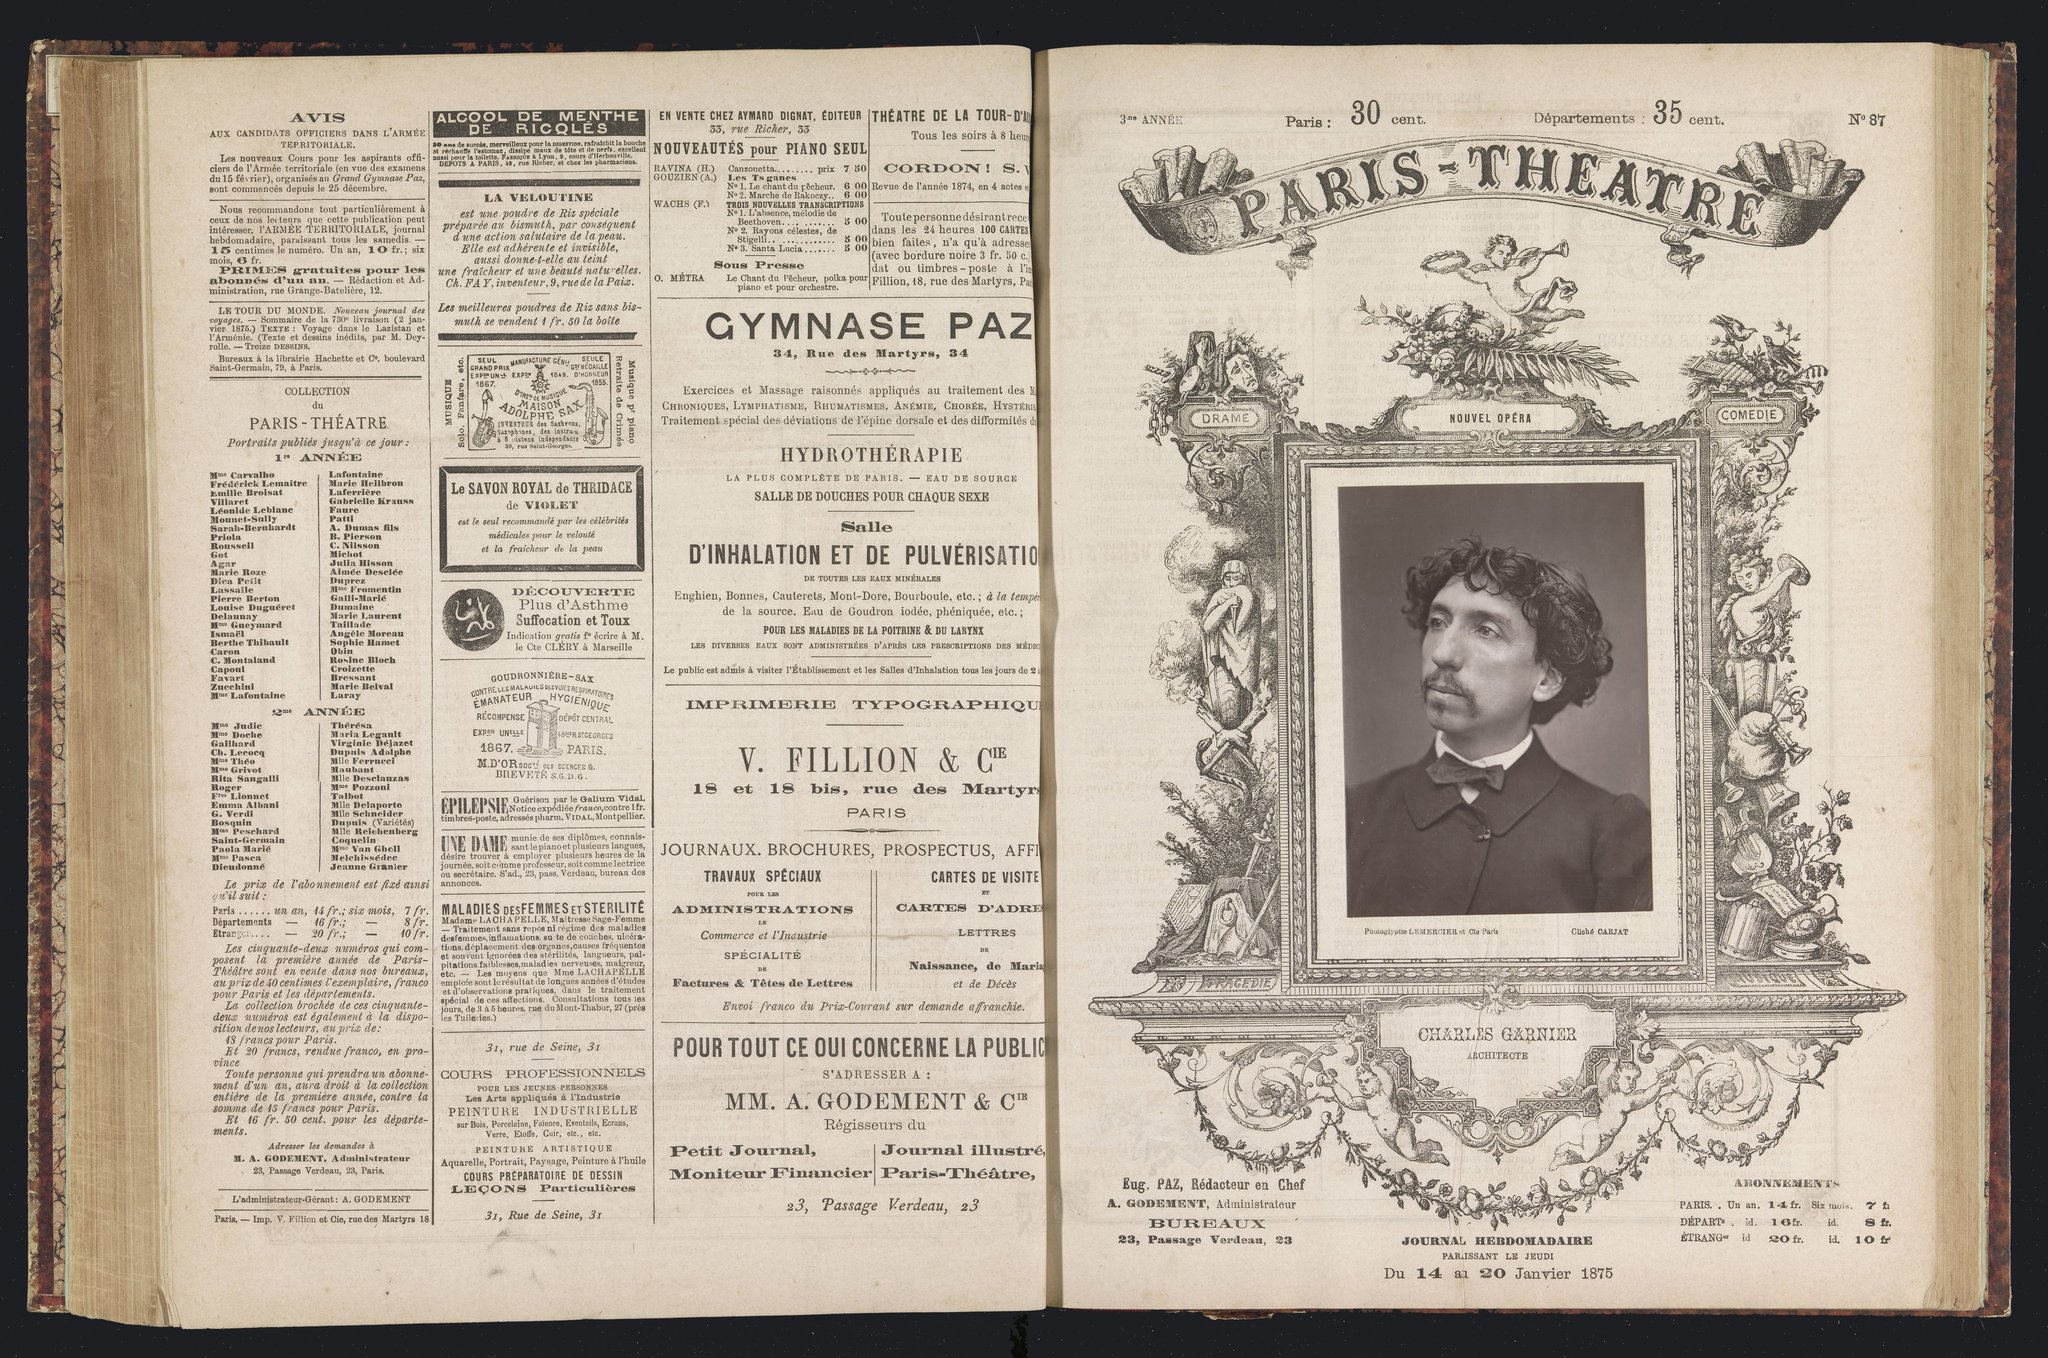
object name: photomechanical print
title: Portret van Charles Garnier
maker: étienne carjat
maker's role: draughtsman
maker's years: 1828-1906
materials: paper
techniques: woodburytype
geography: paris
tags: portrait, self-portrait of architect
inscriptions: inscription: ‘Journal hebdomadaire paraissant le jeudi Du 14 au 20 Janvier 1875’, number: ‘No 87’